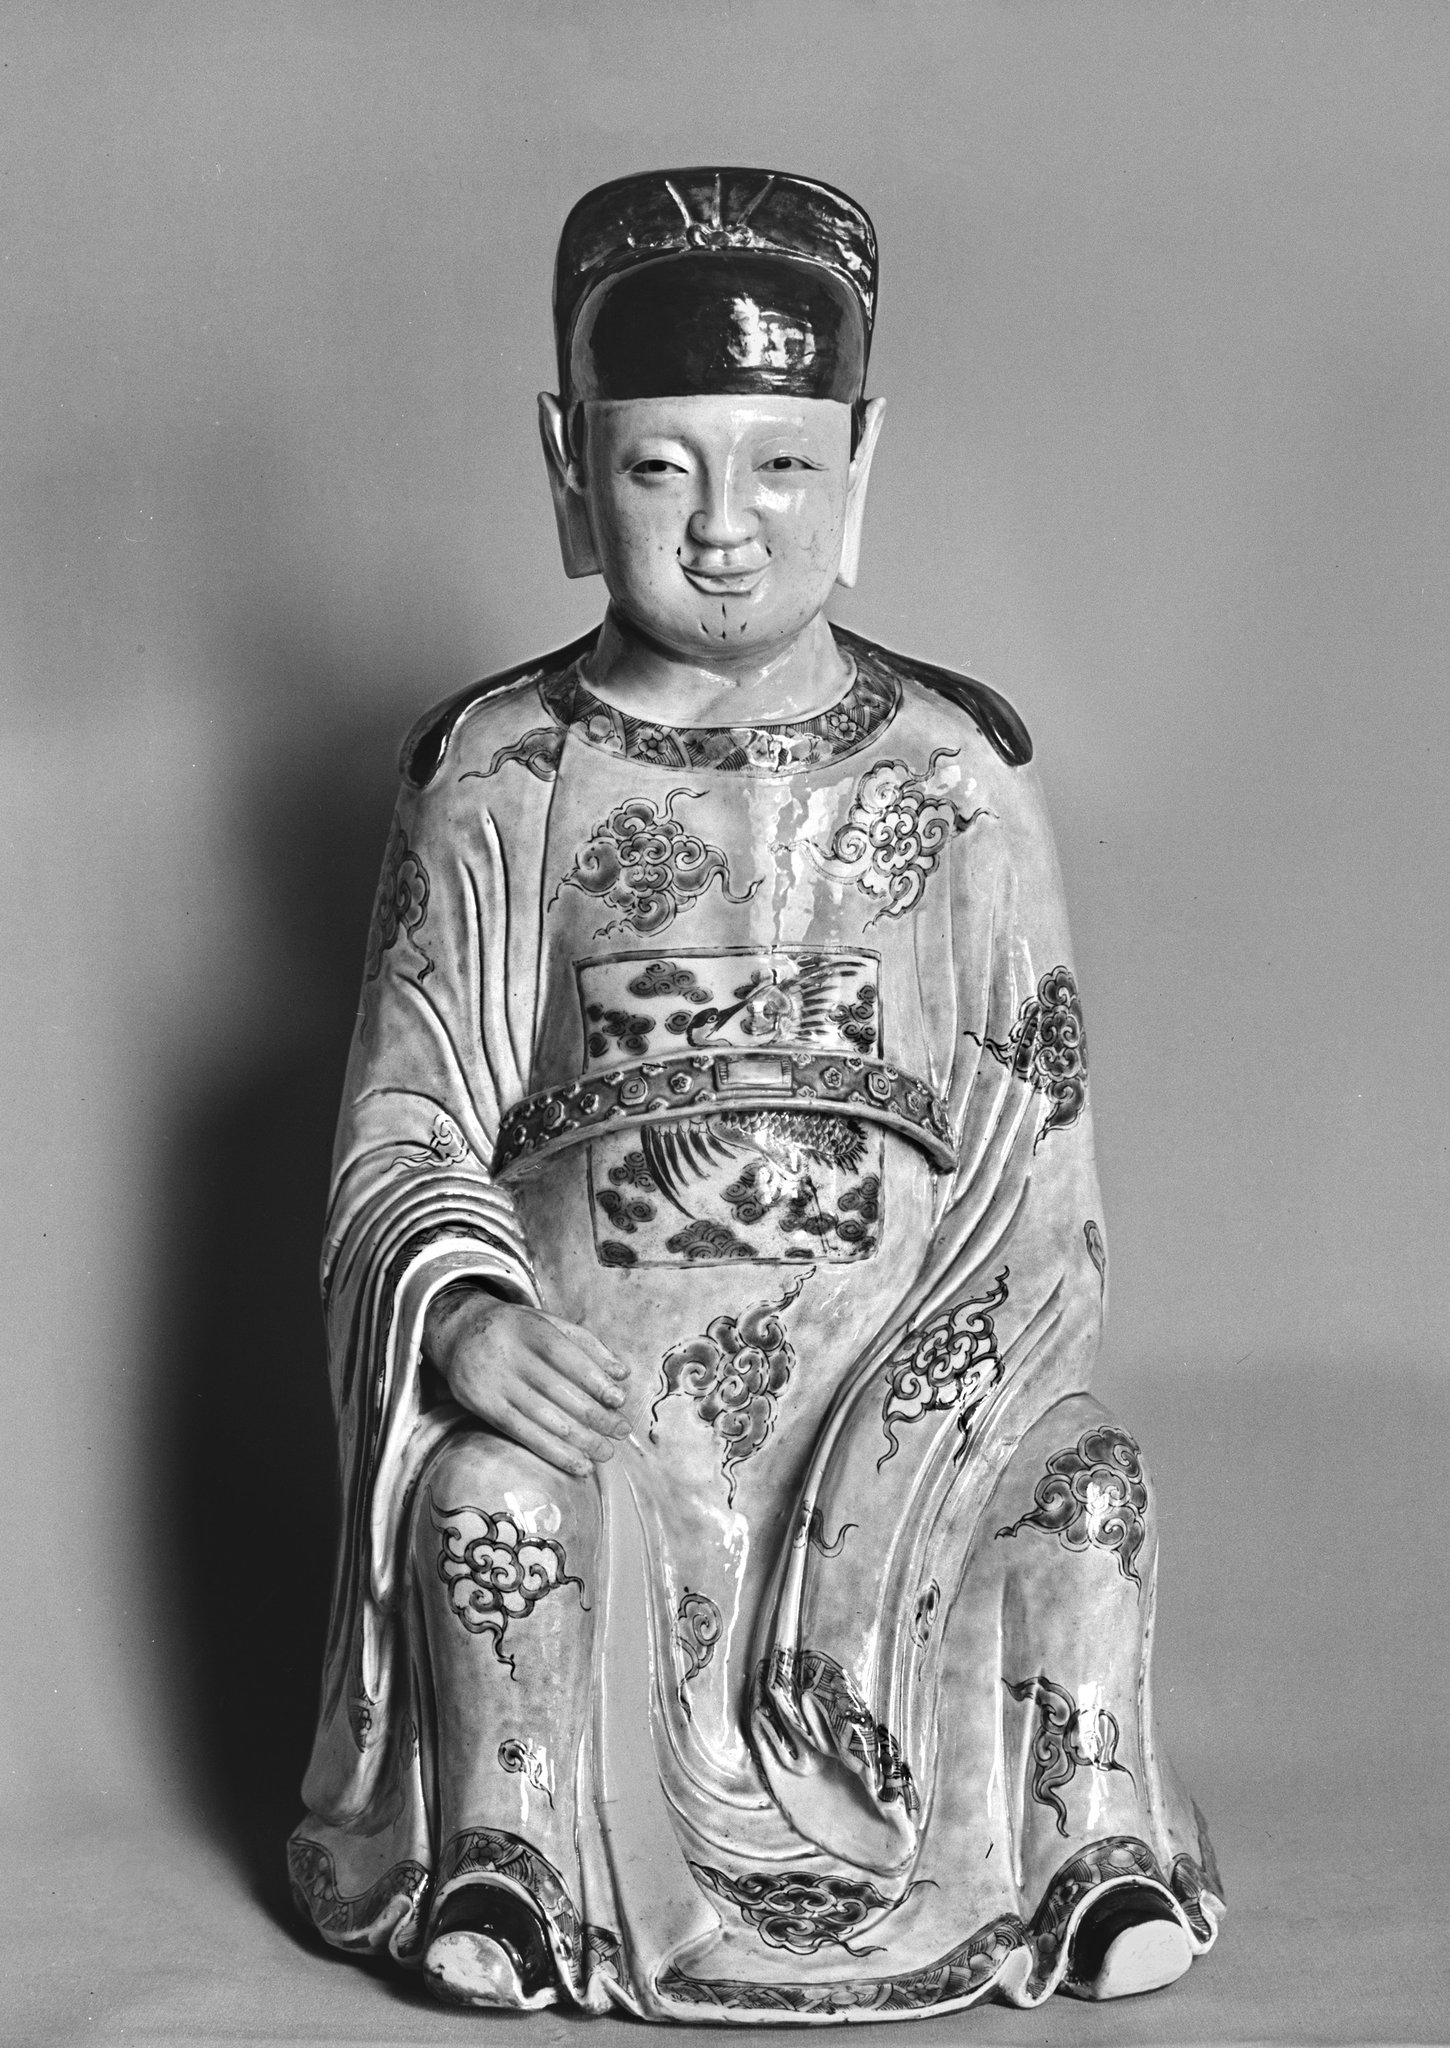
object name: figure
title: Figure with Court Headdress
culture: chinese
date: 1662-1722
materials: porcelain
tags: men